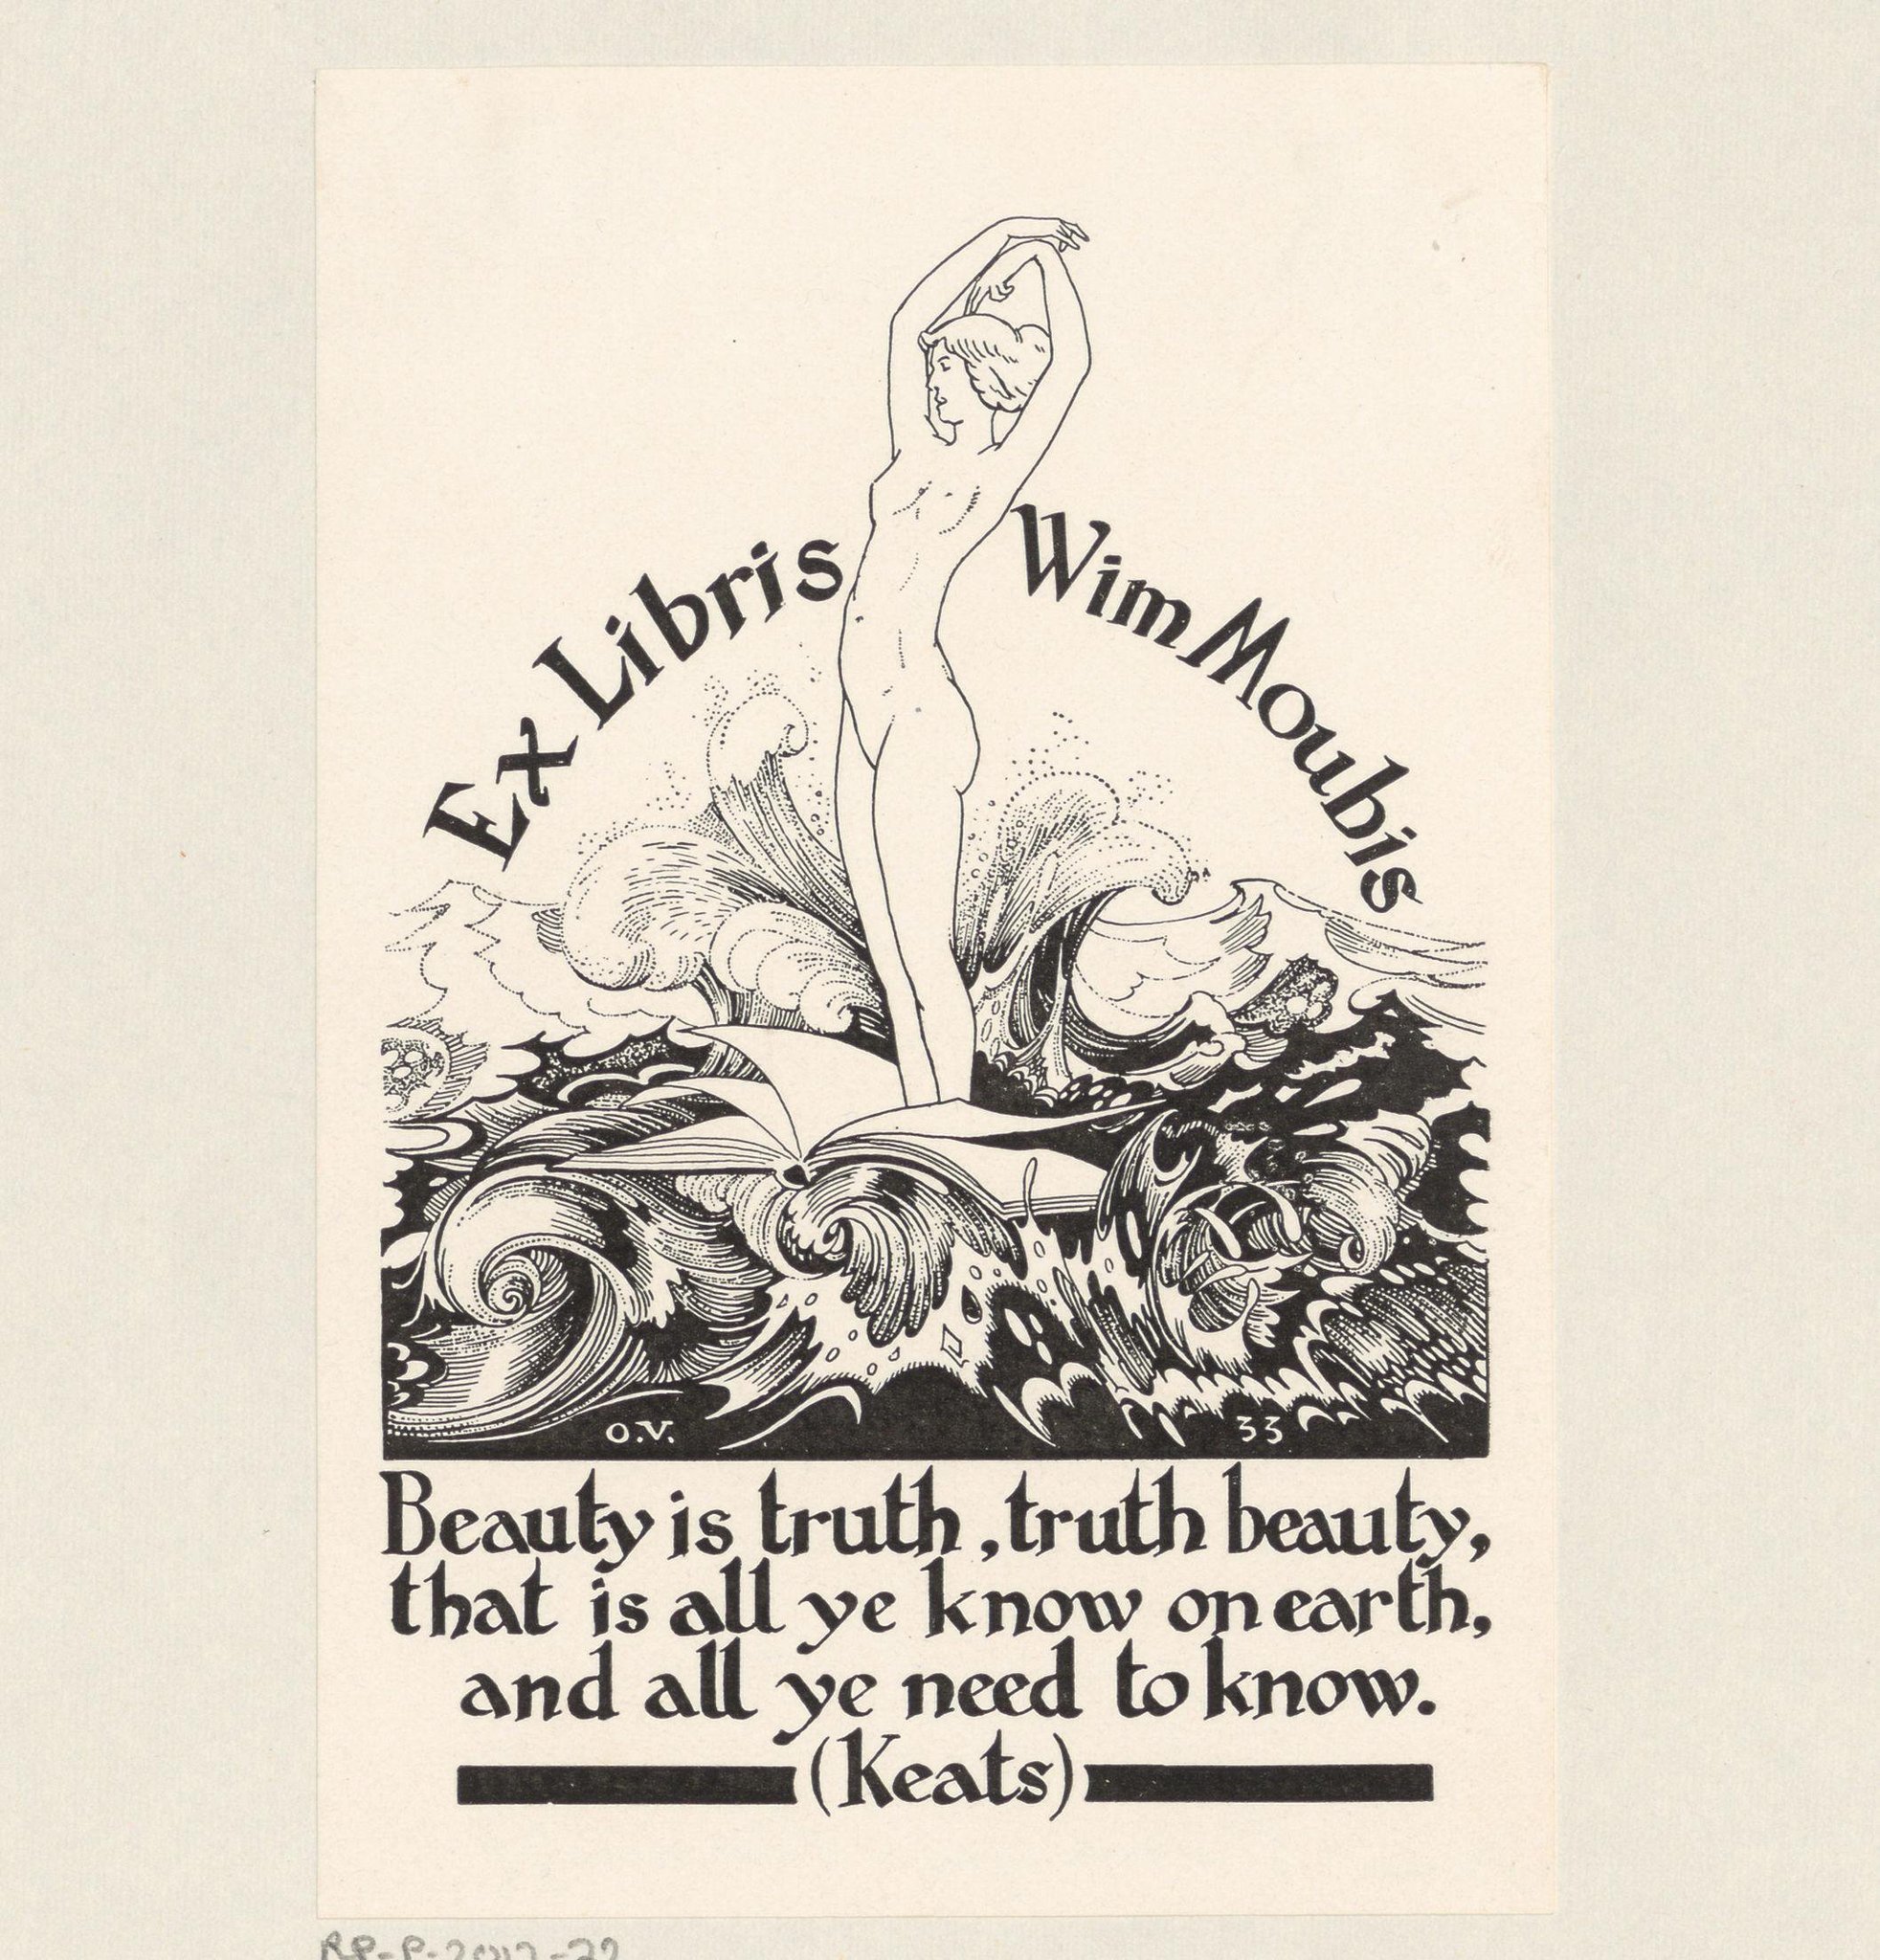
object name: bookplate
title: Ex libris van Wim Moubis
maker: otto verhagen (i)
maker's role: draughtsman, print maker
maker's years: 1885-1951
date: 1933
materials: paper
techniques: printing block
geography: noordwijk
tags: wave, birth of venus; venus anadyomene: after uranus' castration venus rises from the sea wringing the water from her hair; usually she is awaited by the hours, book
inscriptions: signature: ‘Ontw. O. Verhagen, Noordwijk’